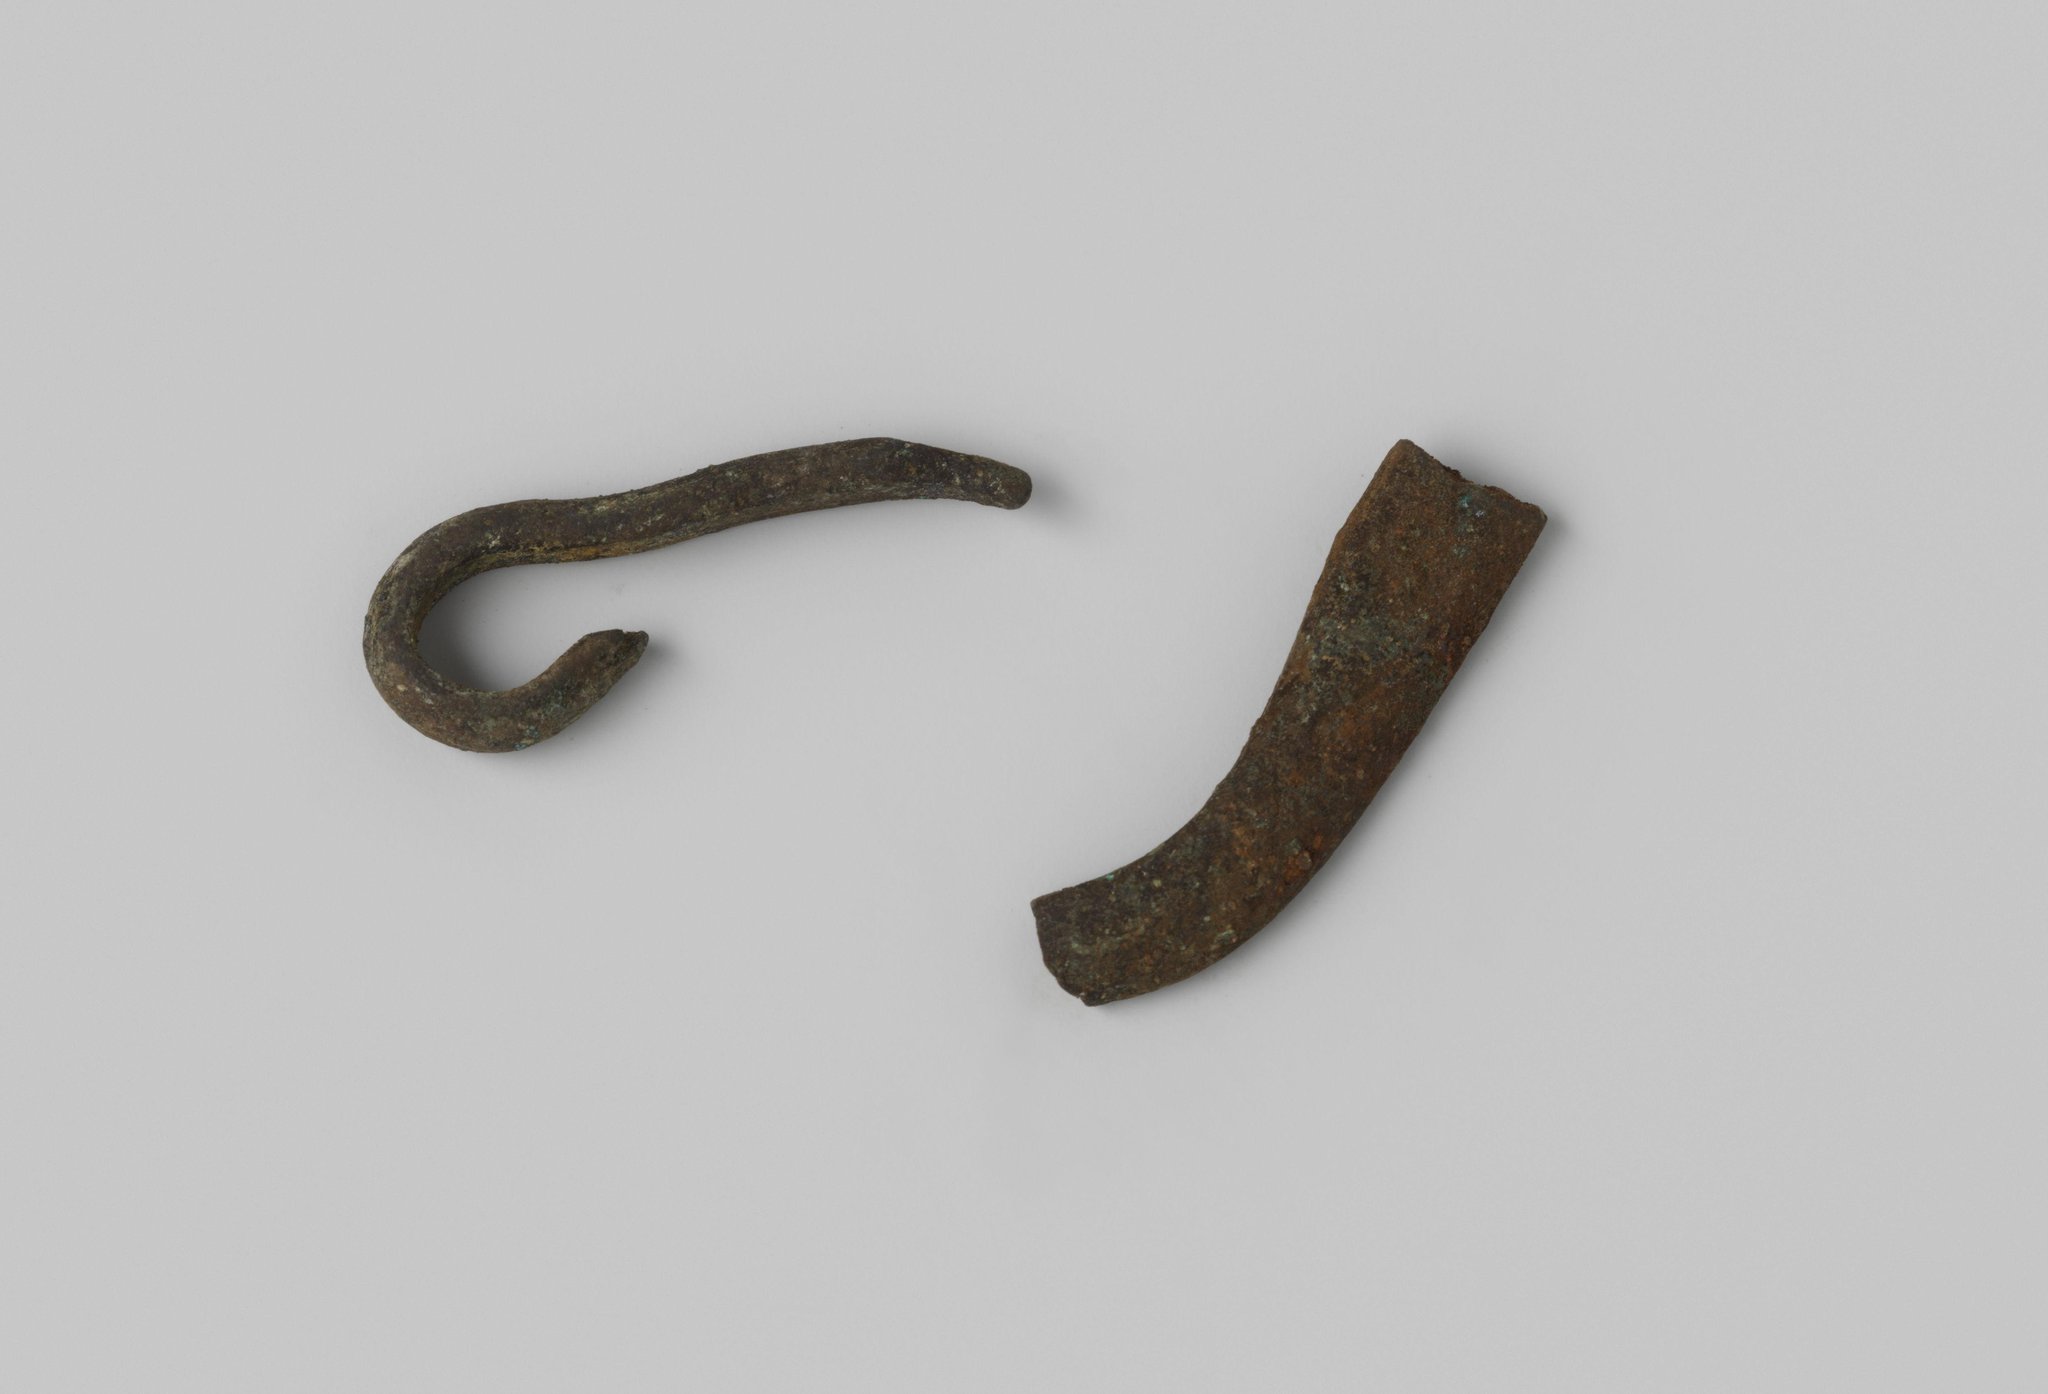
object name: buckle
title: Pin en fragment van een gesp uit het wrak van de Oost-Indiëvaarder Hollandia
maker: Anonymous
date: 1700-1743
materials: copper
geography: netherlands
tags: verenigde oostindische compagnie, hollandia (schip), annet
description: Buckle, tongue; looped wire, pointed end.